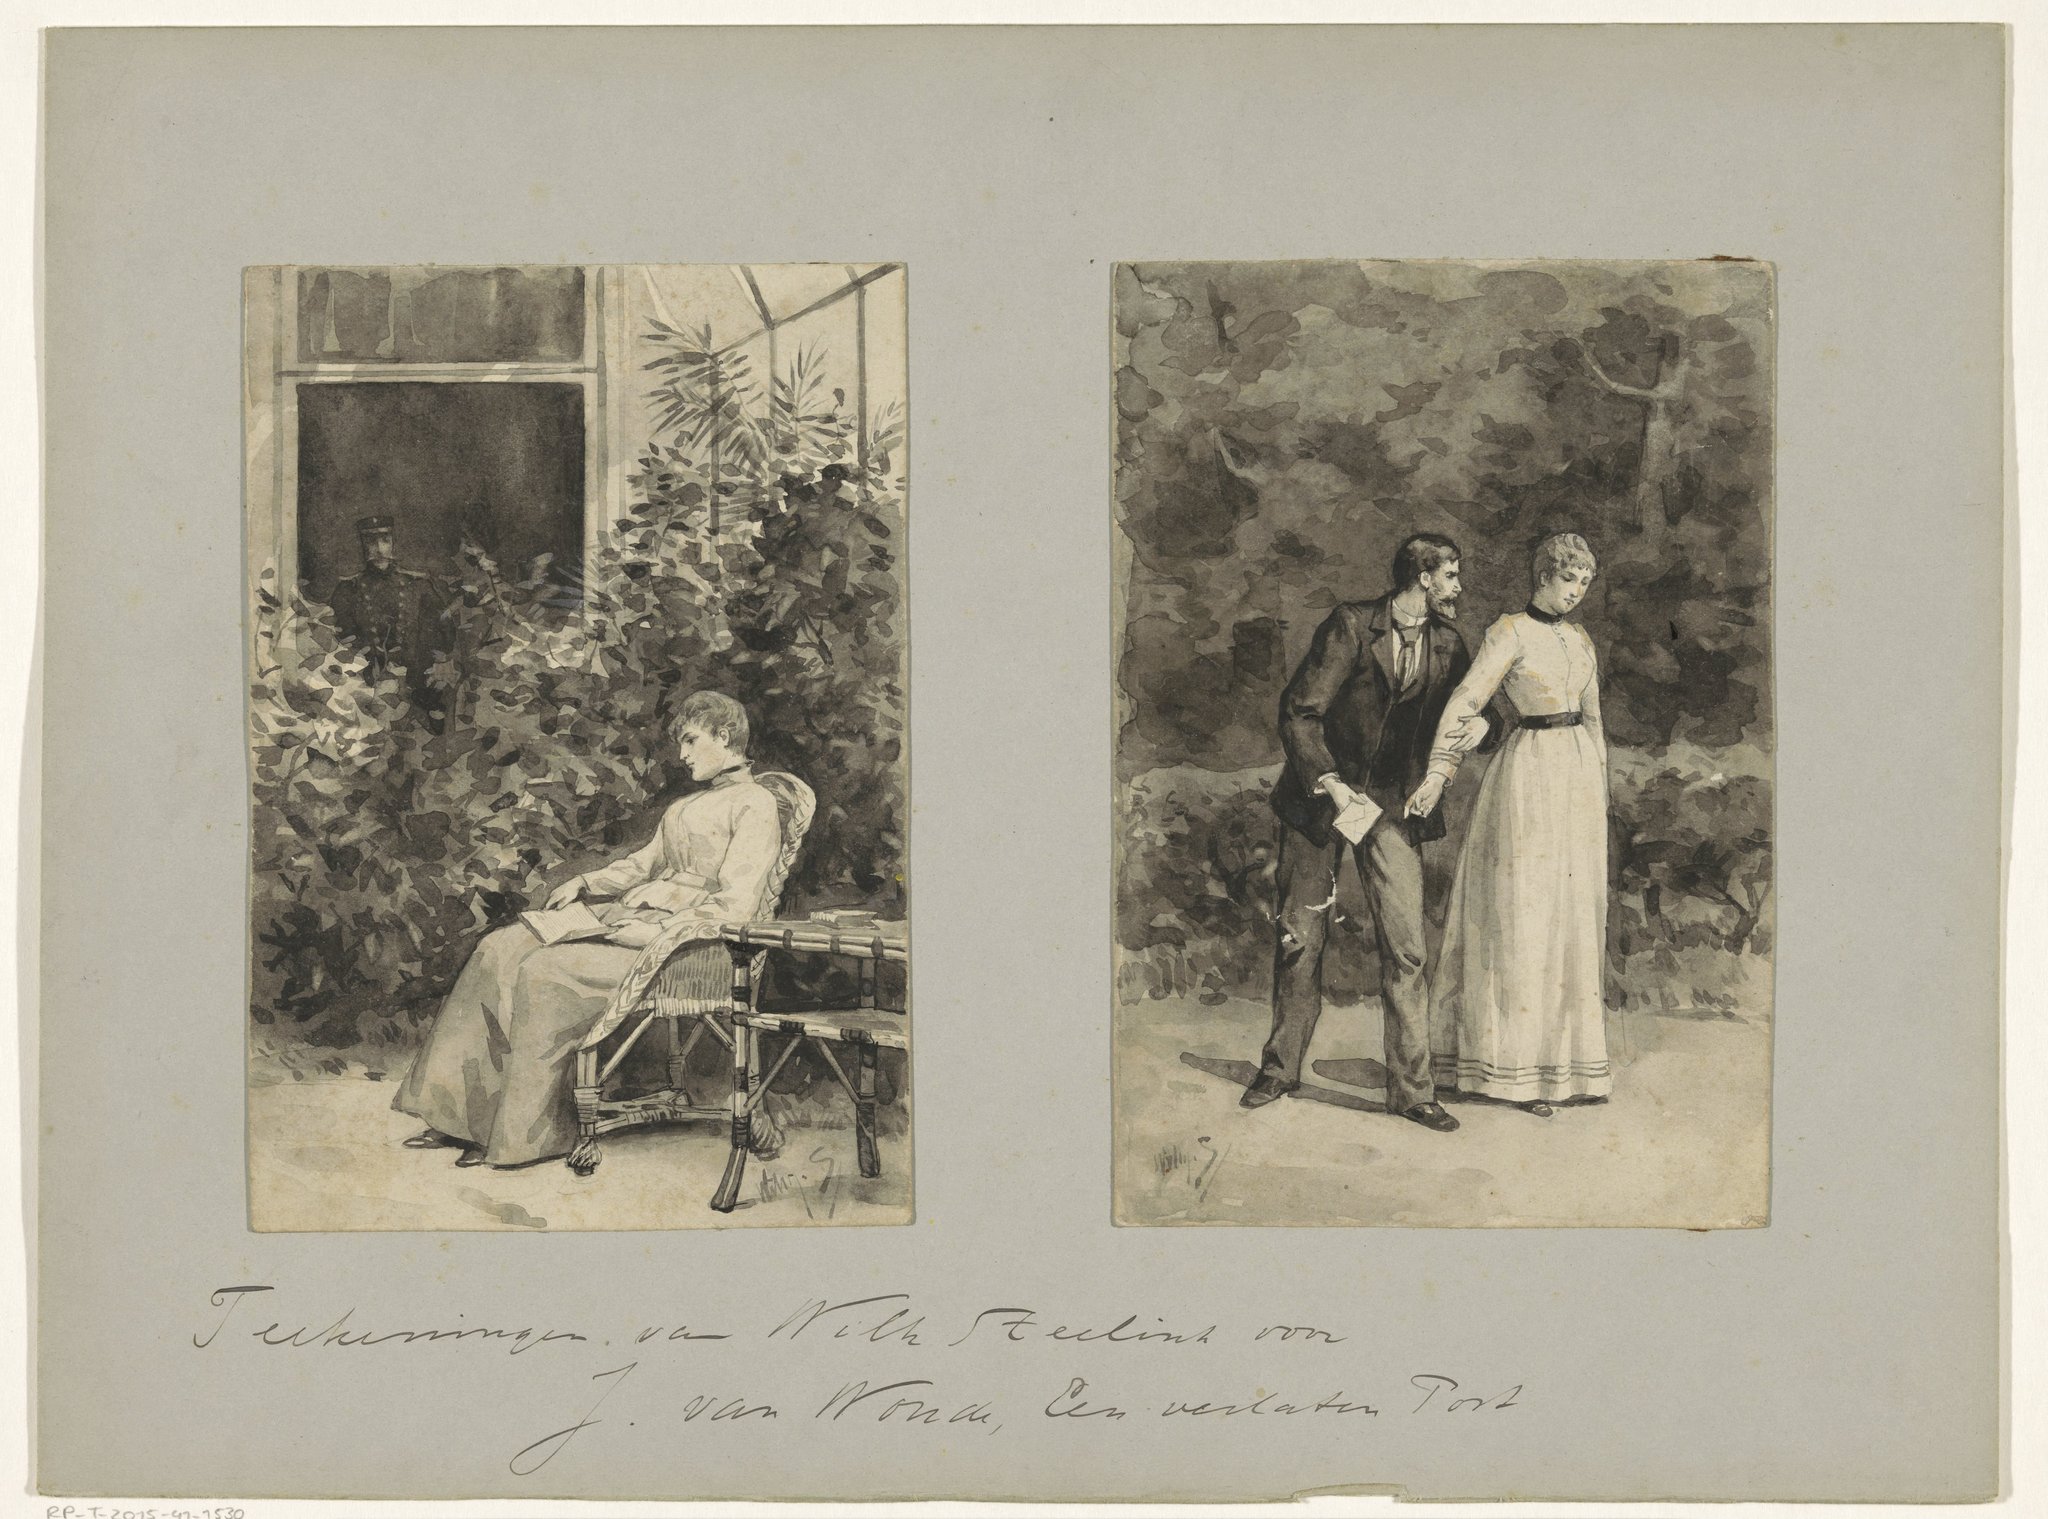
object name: drawing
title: Dagdromende vrouw en een man met brief bij een vrouw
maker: willem steelink (ii)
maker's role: draughtsman, print maker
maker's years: 1856-1928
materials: cardboard, ink, paper, pencil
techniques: brush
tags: sitting figure - aa - female human figure, letter, envelope, (military) uniforms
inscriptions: annotation: ‘Teekeningen van Wilm Steelink voor/ J. van Woude, Een verlaten Post’, signature: ‘Wilm. S/ Wilm. S’, collector's mark: Lugt 2228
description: Twee boekillustraties. Links zit een vrouw in een stoel in een tuin of serre. Ze heeft een boek op schoot en staart voor zich uit. In de achtergrond is een man in een militair uniform te zien. Rechts trekt een man met een brief aan de arm van de vrouw. In de achtergrond bomen en struikgewas.